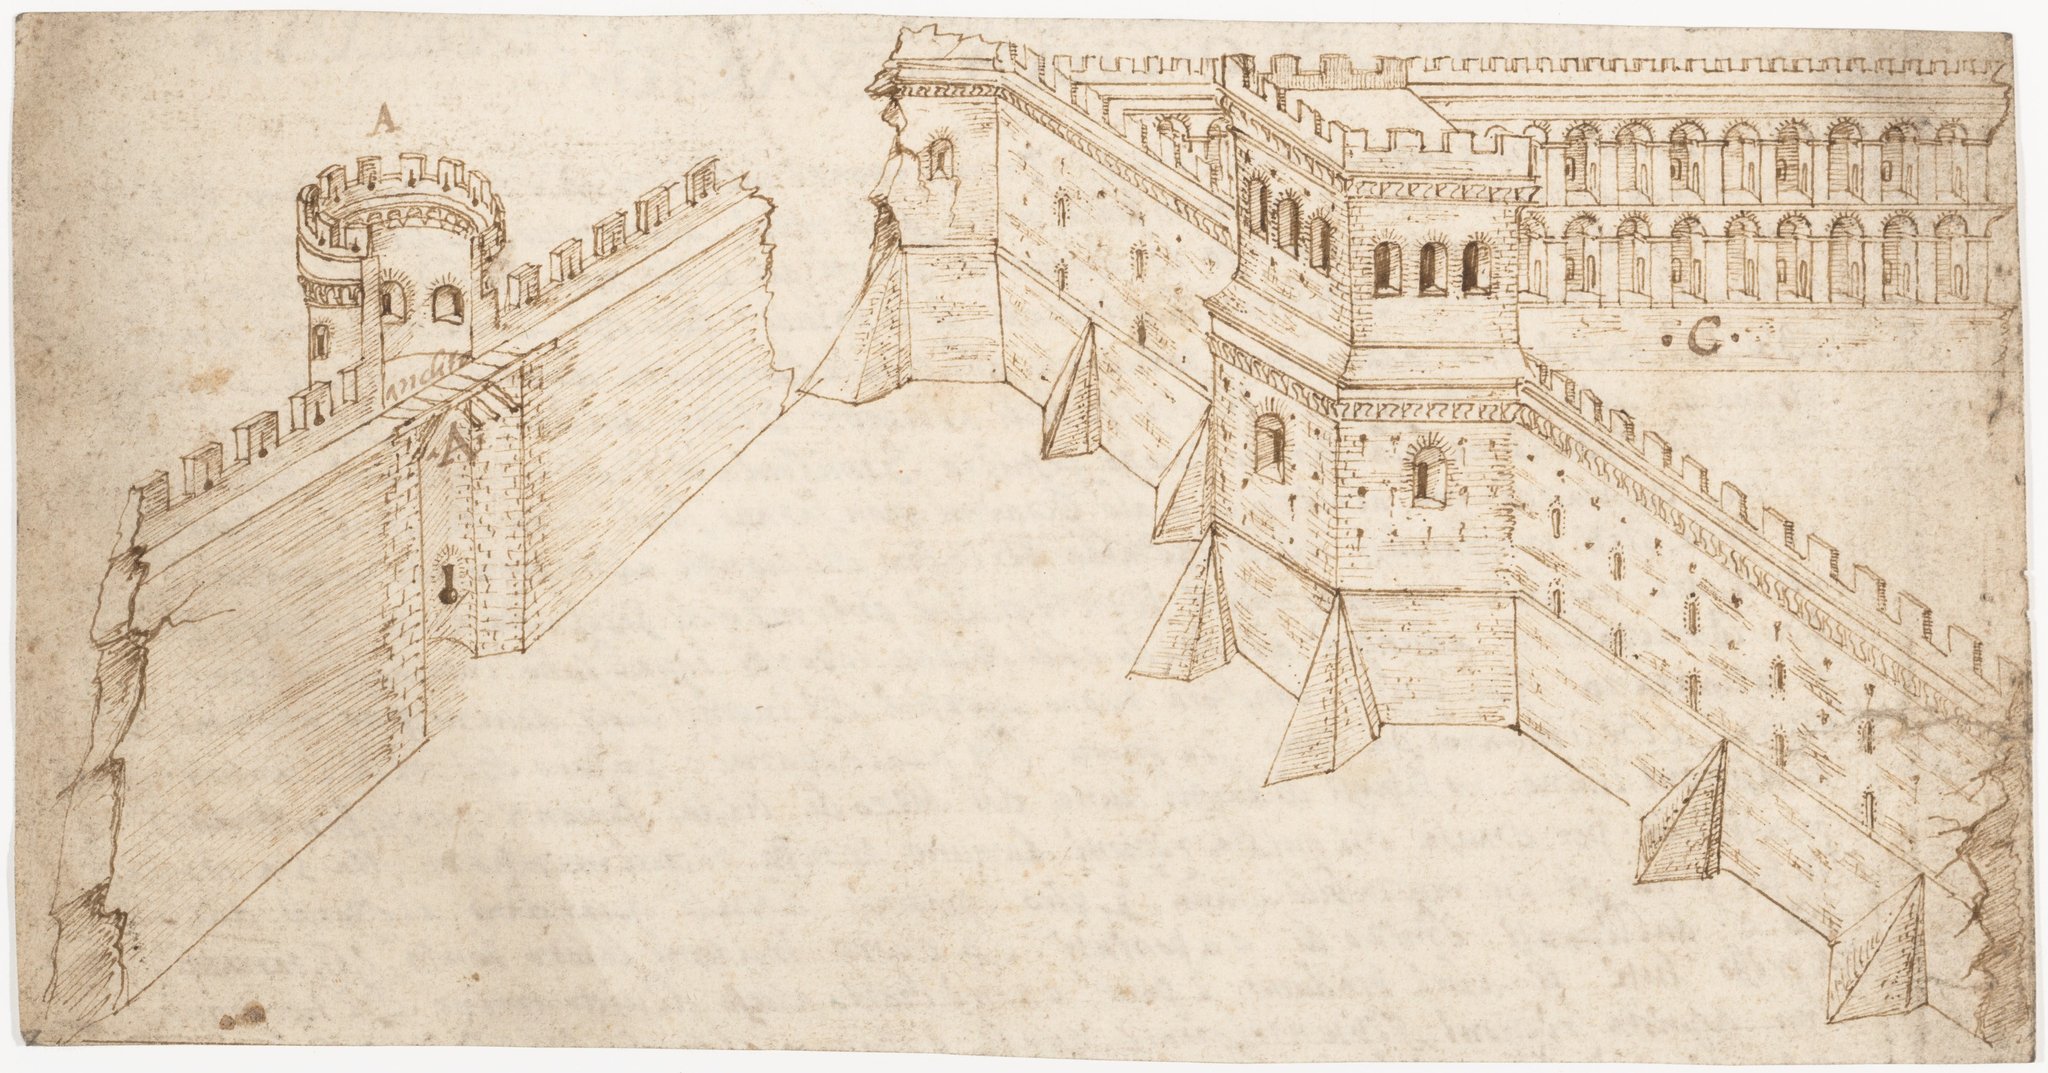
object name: drawing ornament architecture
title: Recto: "Libro Primo, Chapo Quarto..." (Vitruvius, Book 1, Chapter 4); Verso: The Fortification of City Walls (Vitruvius, Book 1, Chapter 5).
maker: sangallo family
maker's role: artist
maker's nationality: italian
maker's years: 1530-1545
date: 1530-1545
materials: ink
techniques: pen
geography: france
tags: buildings,fortification